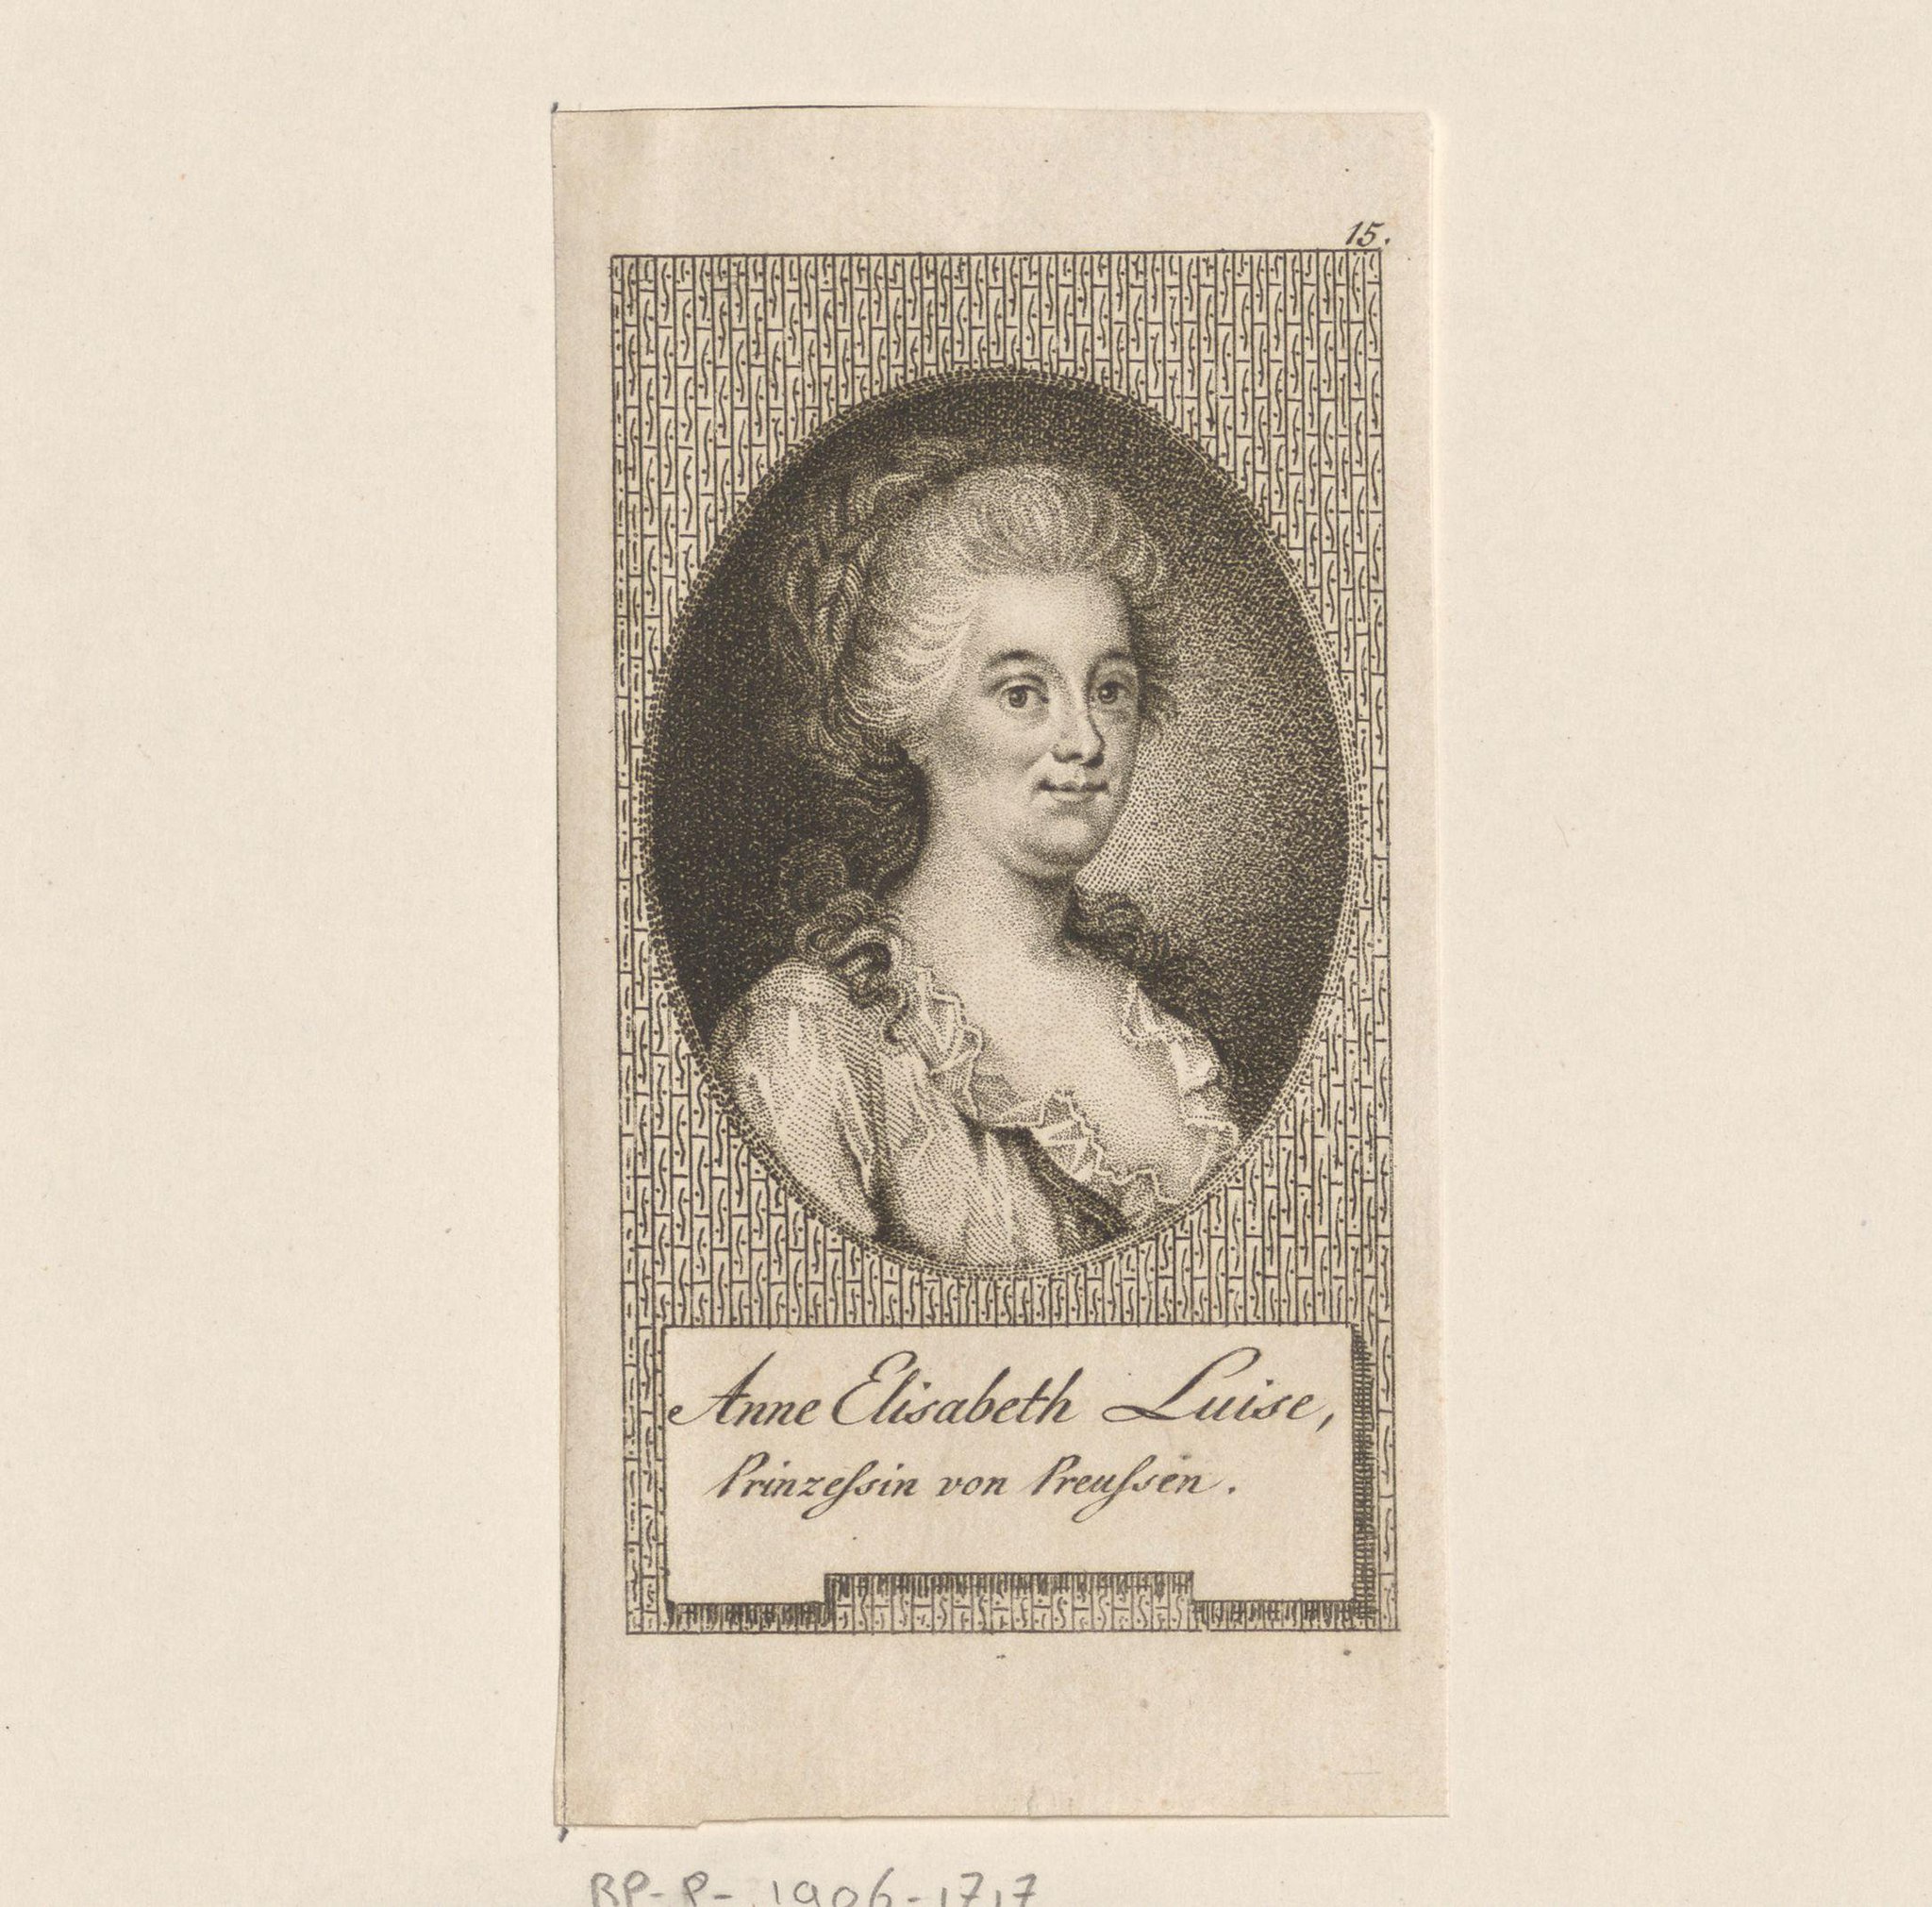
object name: print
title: Portret van Anna Elisabeth Louise van Brandenburg-Schwedt, prinses van Pruisen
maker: Anonymous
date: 1750-1799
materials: paper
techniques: etching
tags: historical persons - bb - woman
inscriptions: collector's mark: Lugt 2228